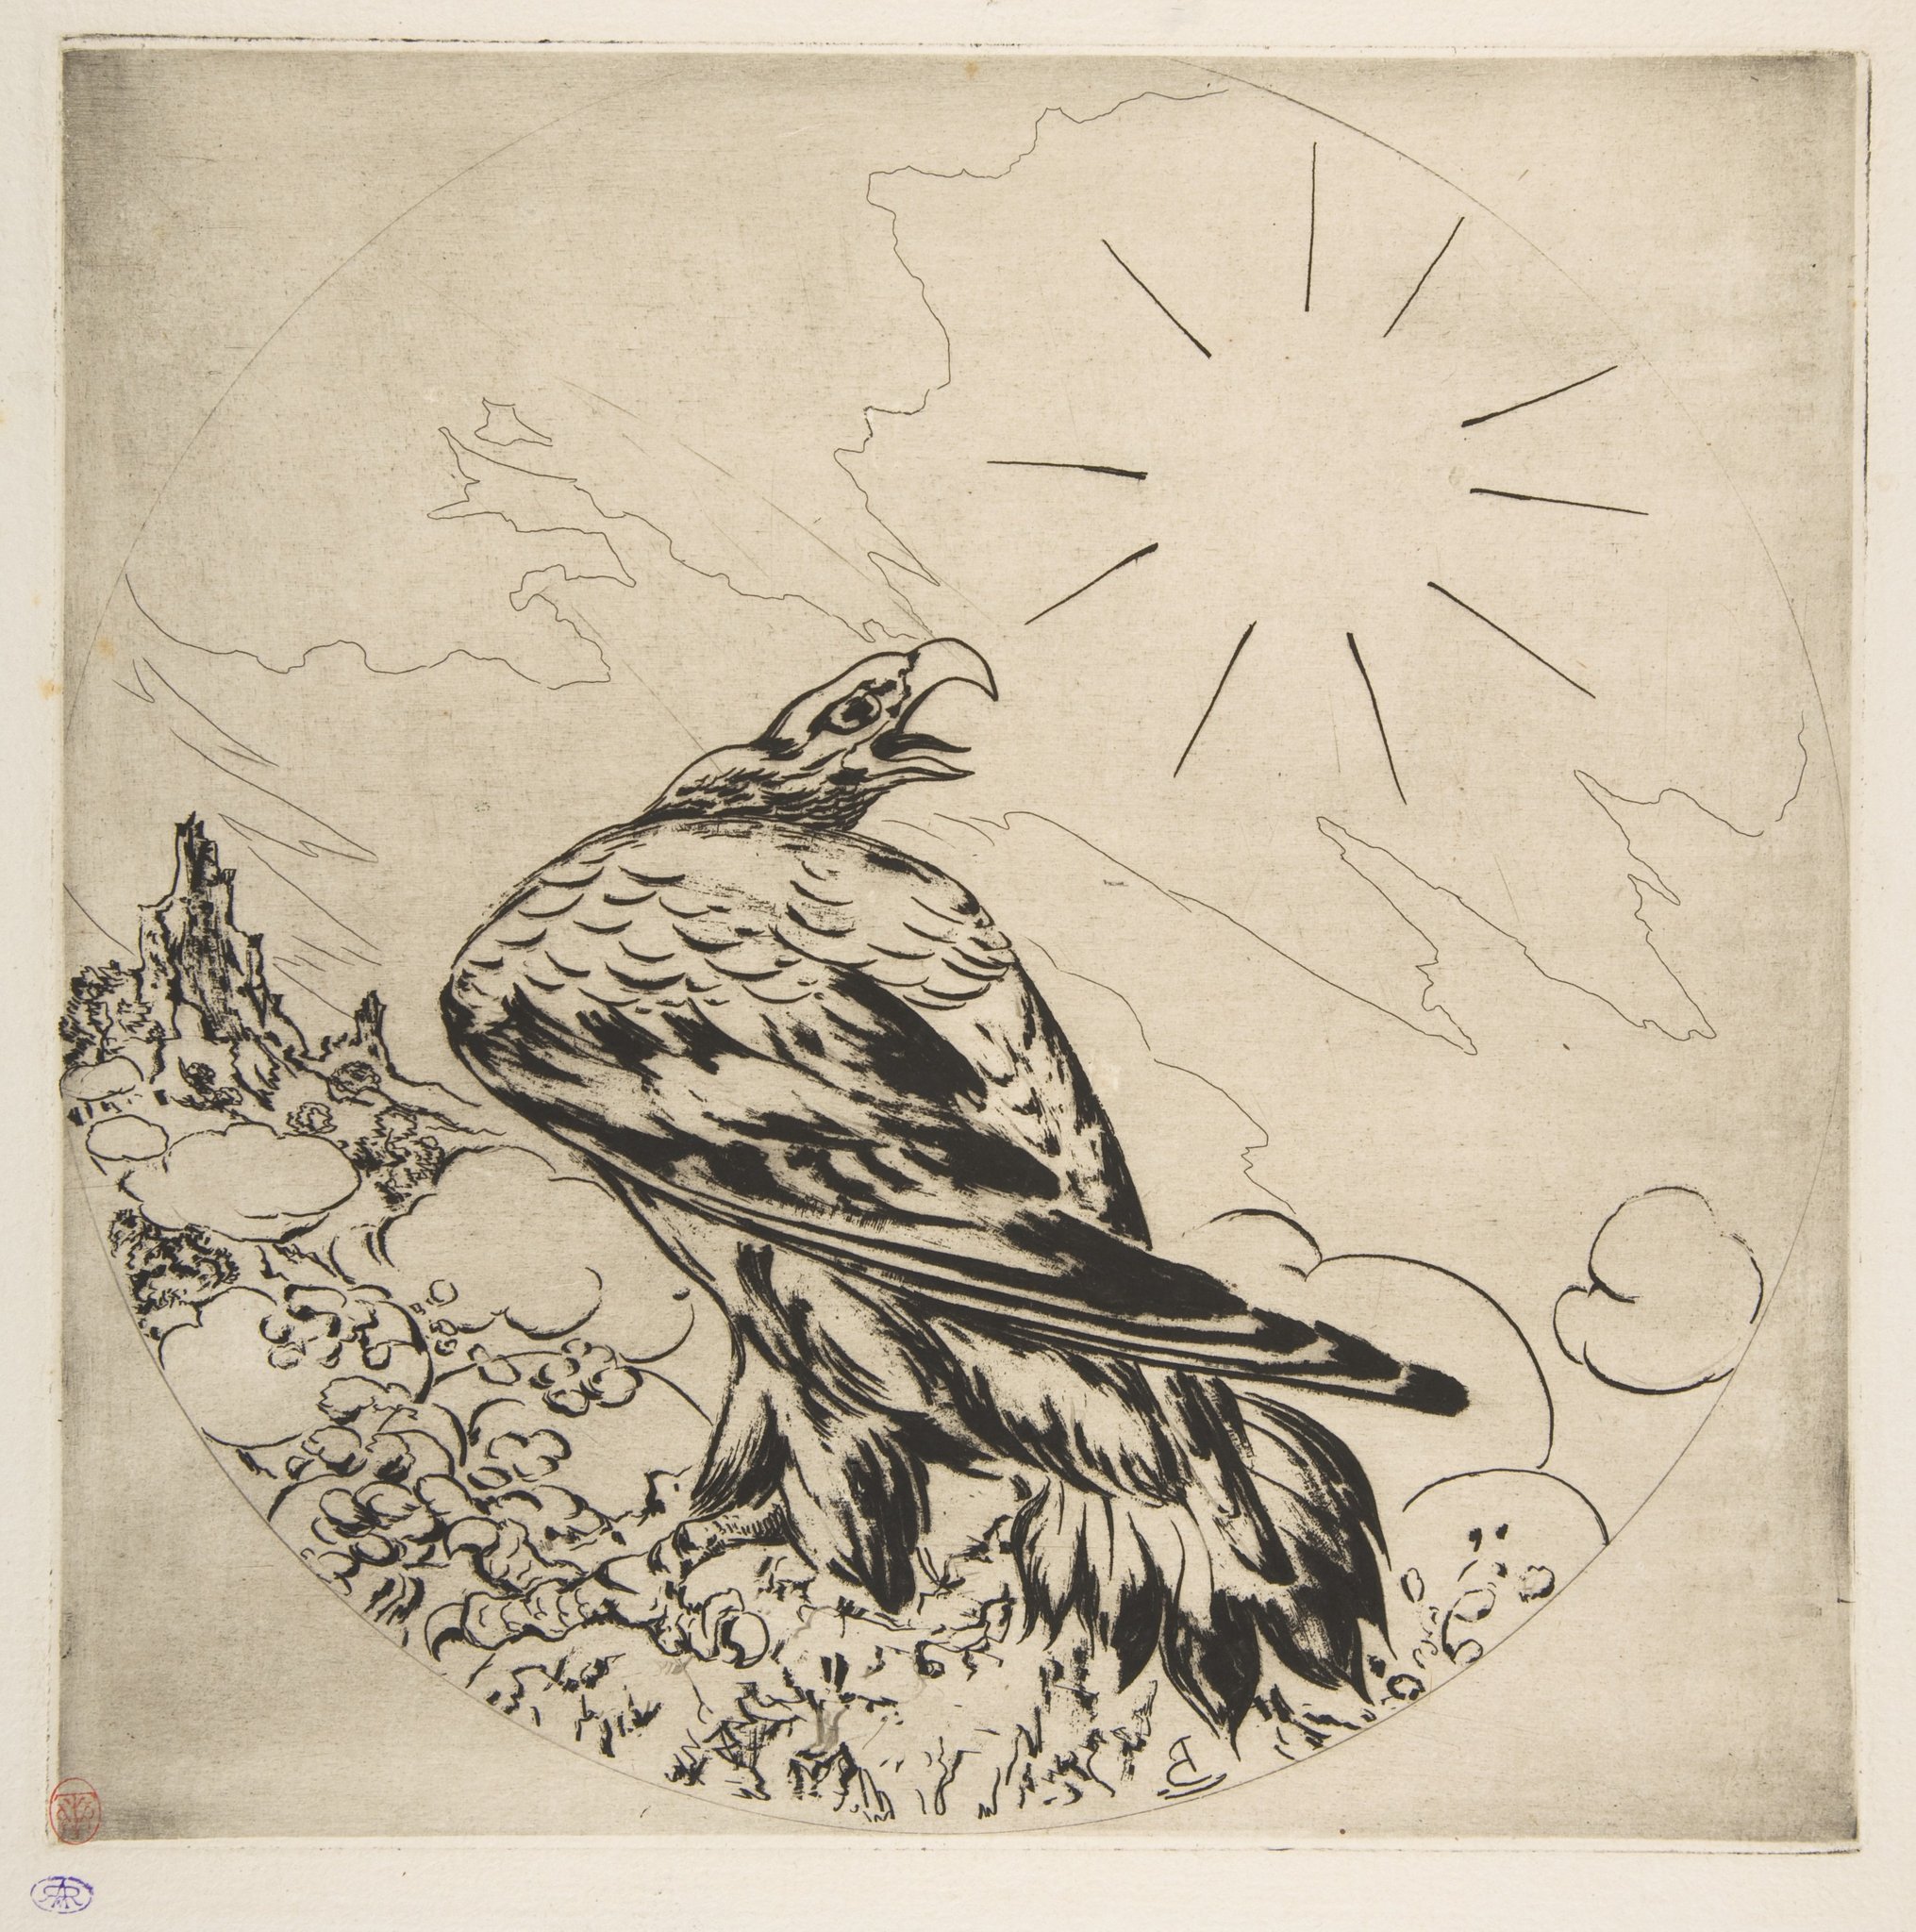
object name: print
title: L'Assiette Républicaine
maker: félix bracquemond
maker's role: artist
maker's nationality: french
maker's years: 1833-1914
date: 1868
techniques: etching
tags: birds